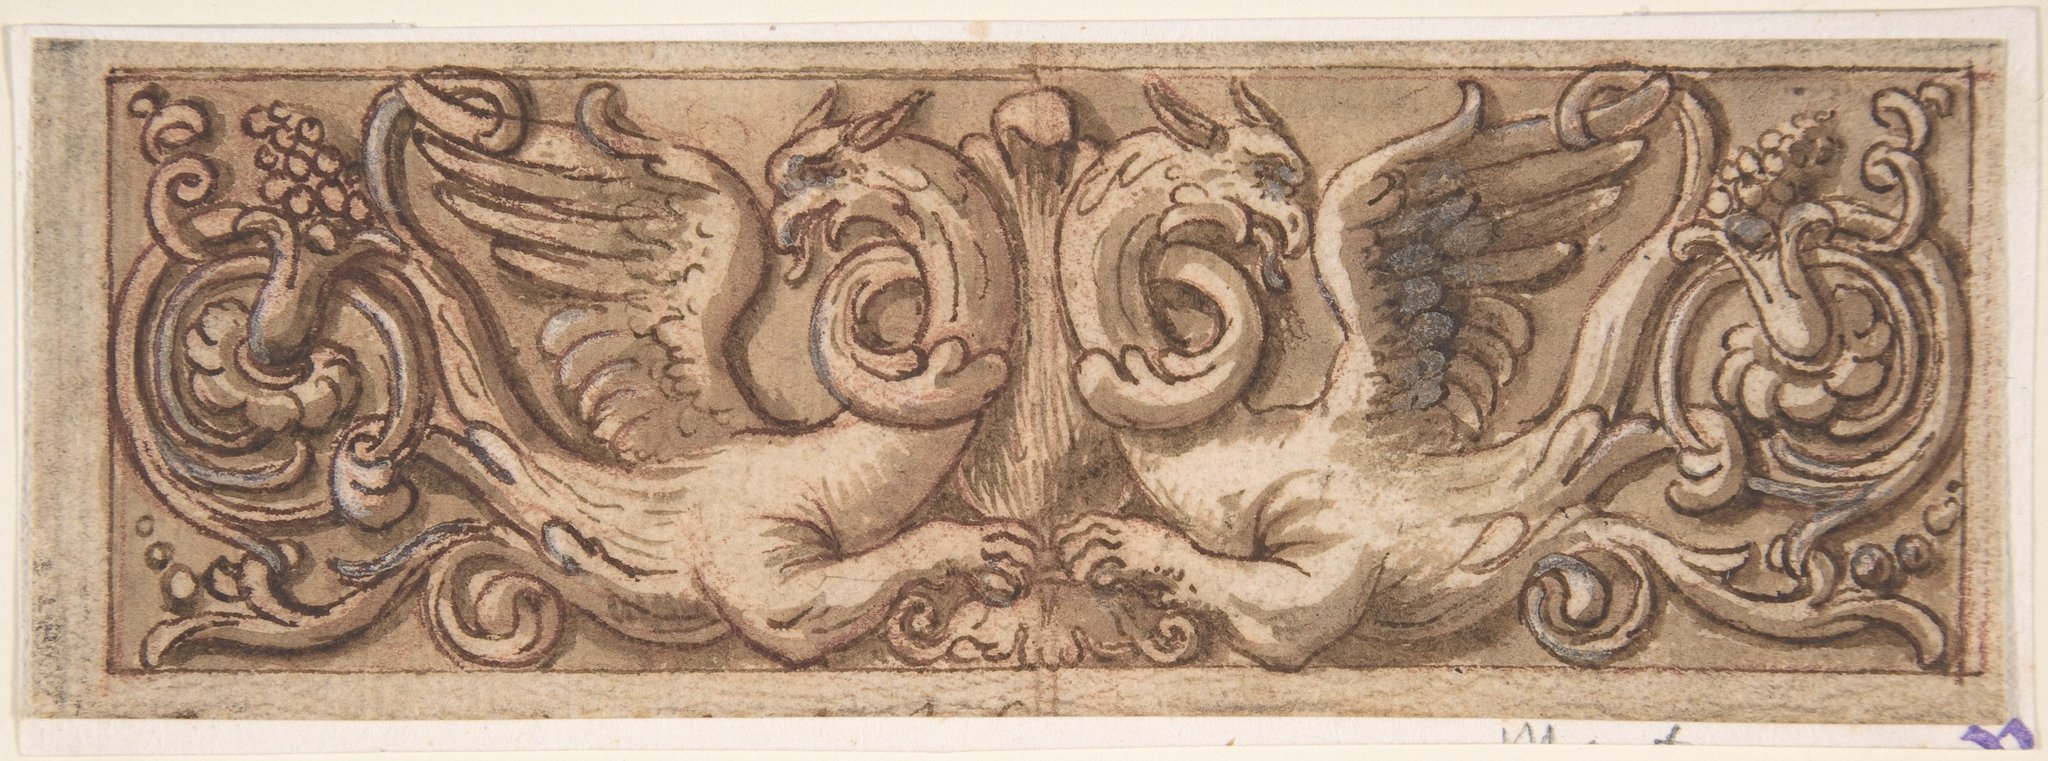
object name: drawing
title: Design for a Frieze with Two Griffins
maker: anonymous, italian, 17th century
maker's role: artist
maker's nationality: italian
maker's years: 1600-1700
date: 1650-1700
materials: chalk, gouache, ink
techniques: brush, highlighting, pen, wash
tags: griffins